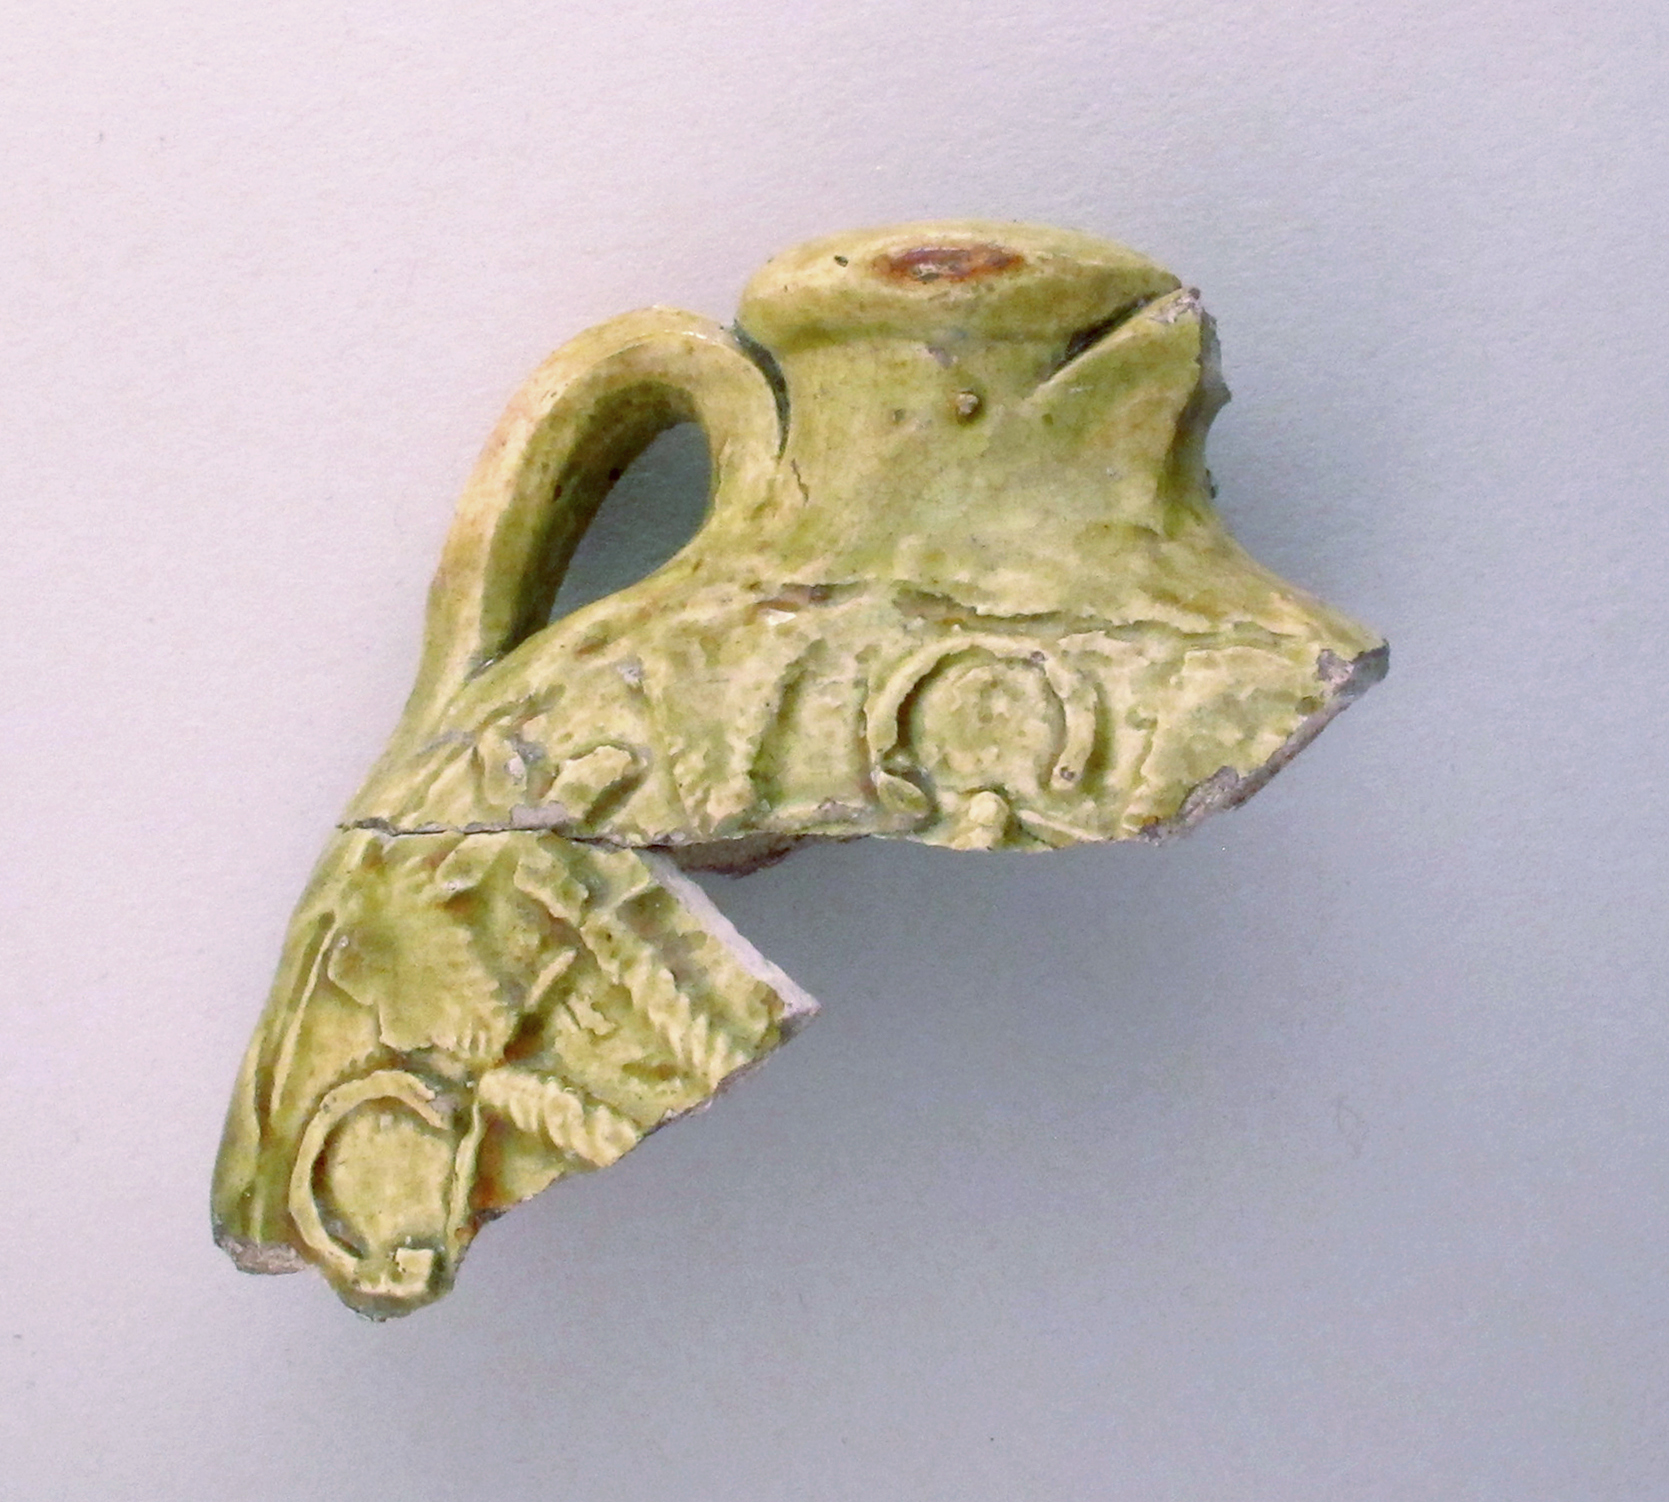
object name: vase fragment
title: Vase fragments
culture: roman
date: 670 BCE-330 CE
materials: terracotta